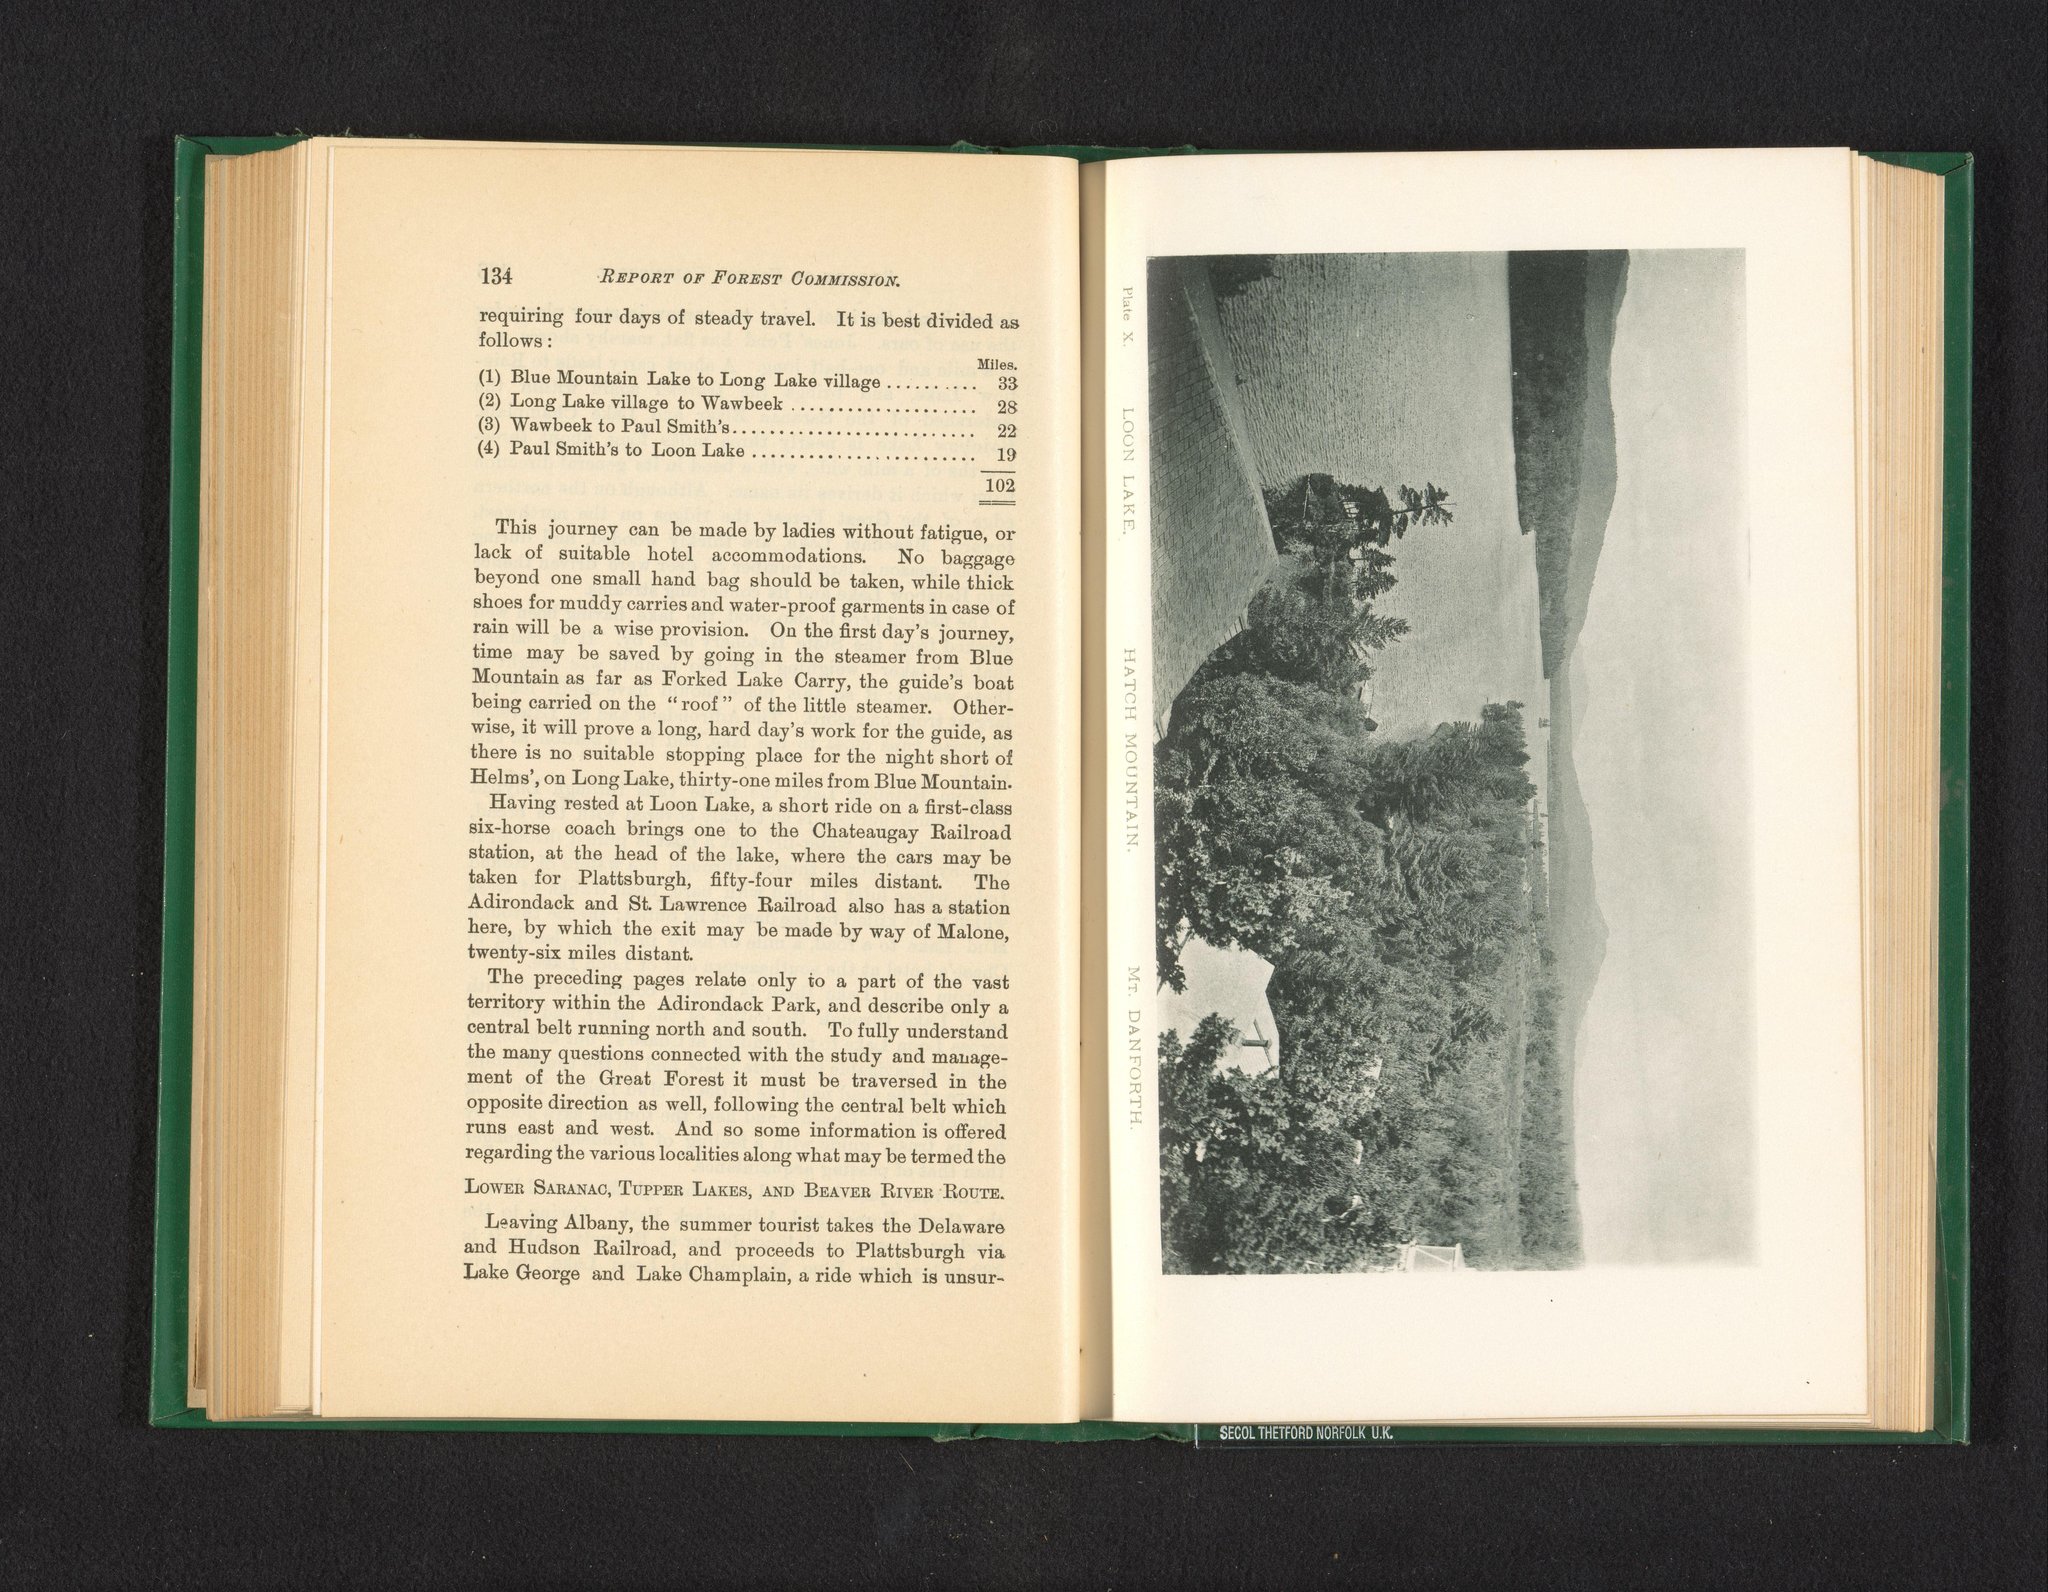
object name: page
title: Loon Lake. Hatch Mountain. Mt. Danforth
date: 1891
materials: paper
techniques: photograph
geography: new york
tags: landscapes with waters, waterscapes, seascapes (in the temperate zone), lake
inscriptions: number: ‘Plate X.’